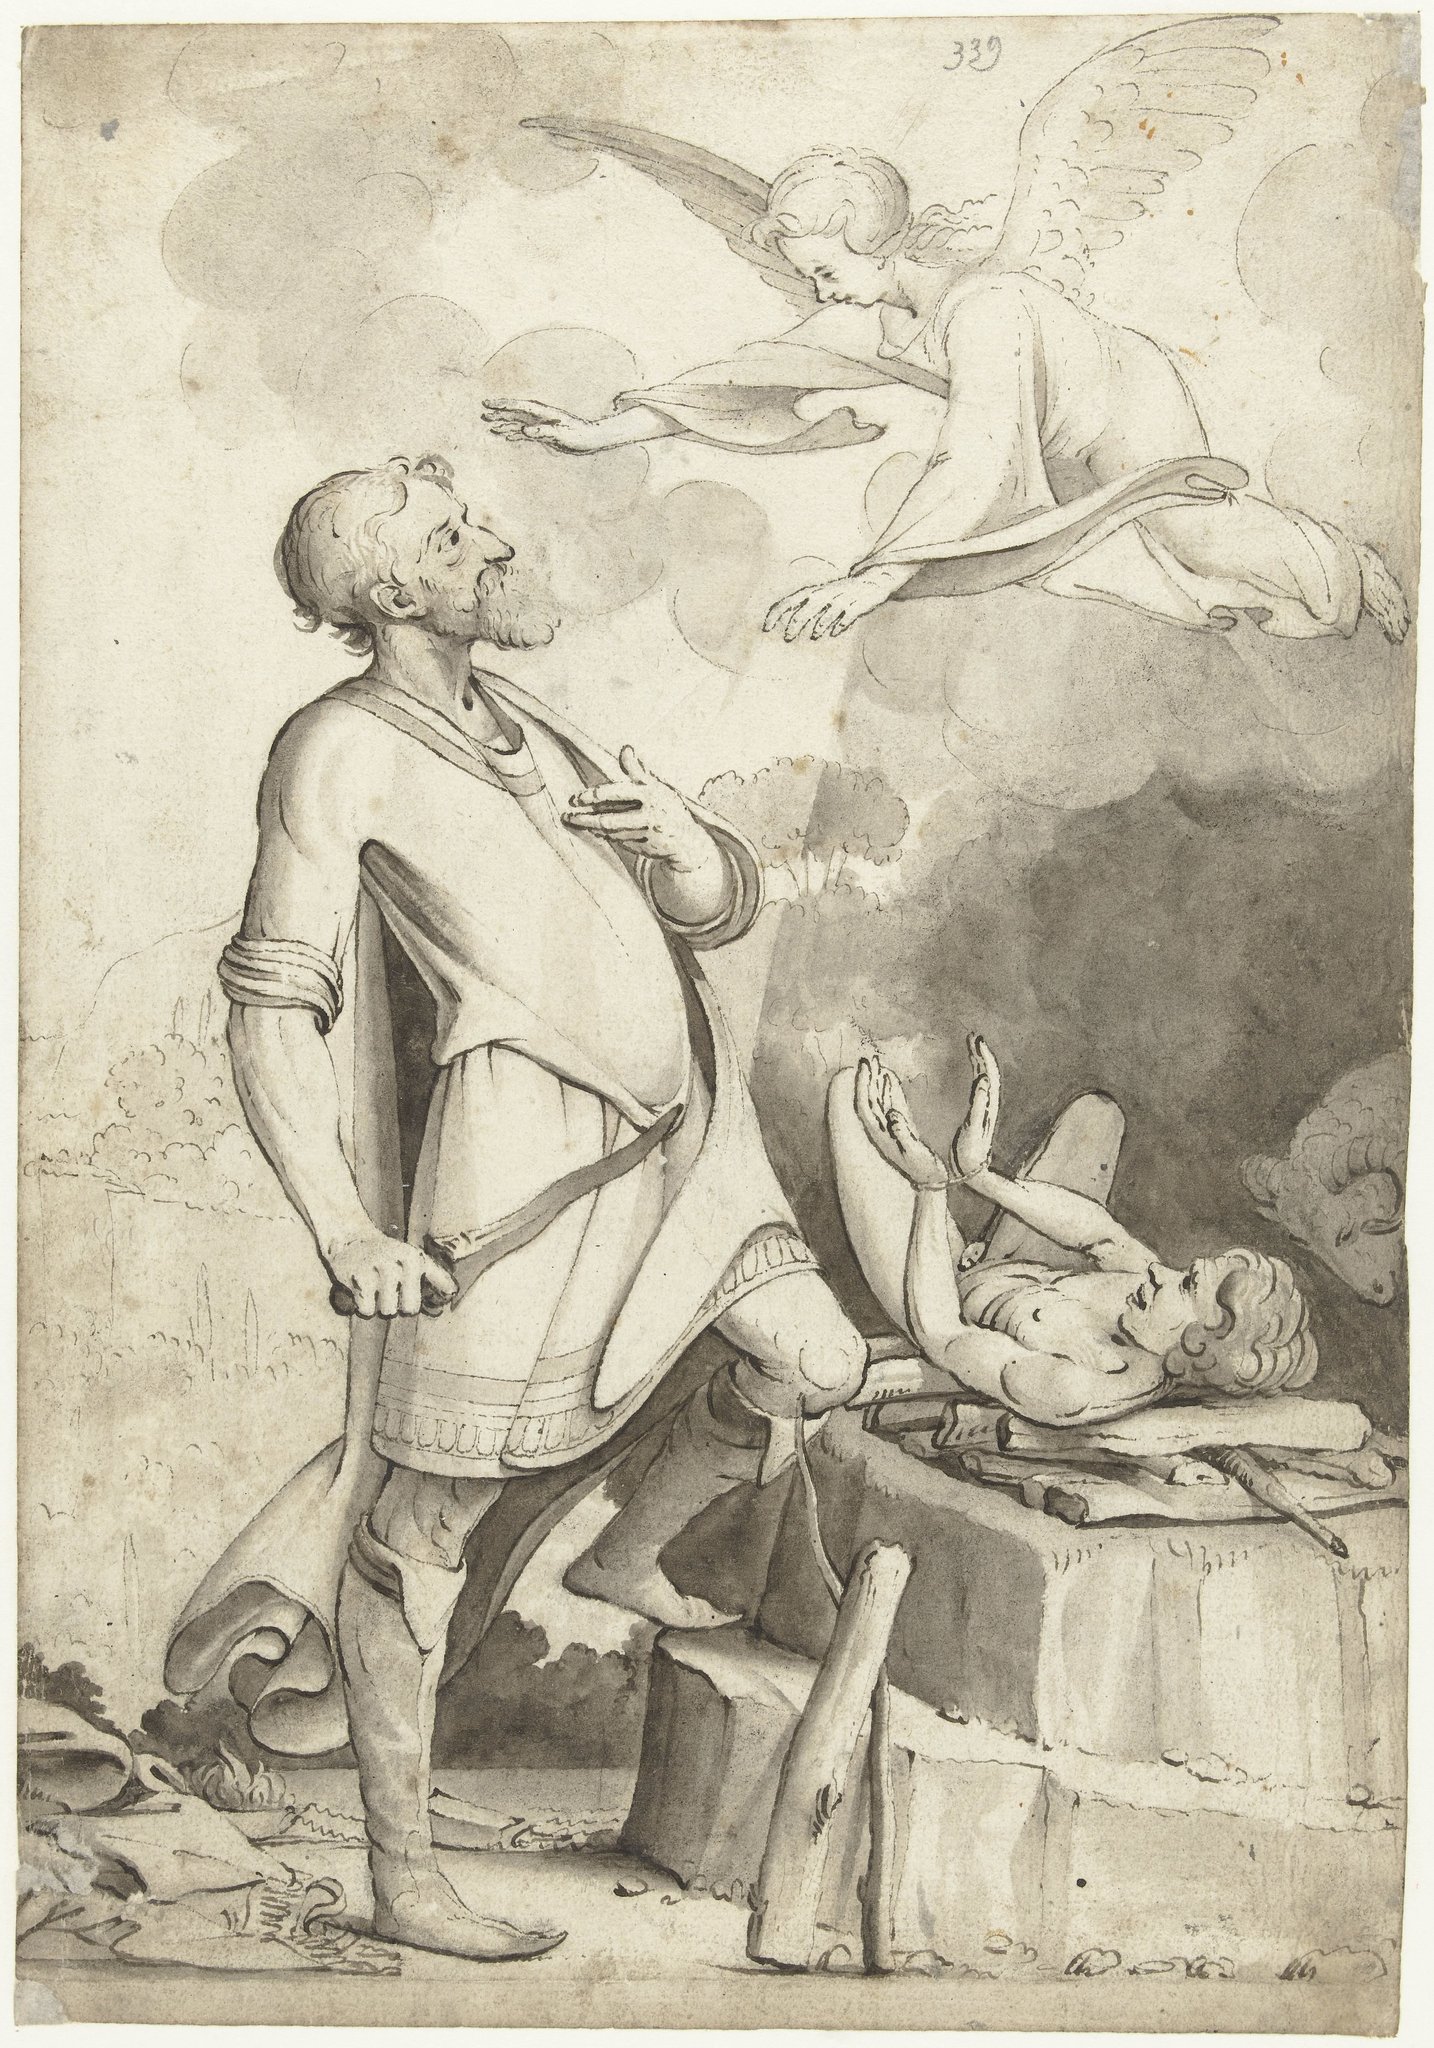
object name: drawing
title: Abraham's offer van Isaac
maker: gerard ter borch (i)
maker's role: draughtsman, print maker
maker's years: 1584-1662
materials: chalk, ink, paper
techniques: brush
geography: zwolle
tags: the sacrifice of isaac (genesis 22)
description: Voorstudie voor schilderij. Nauw verwant aan schilderij in Provinciaal Overijssels Museum, Zwolle, "Het offer van Isaac".